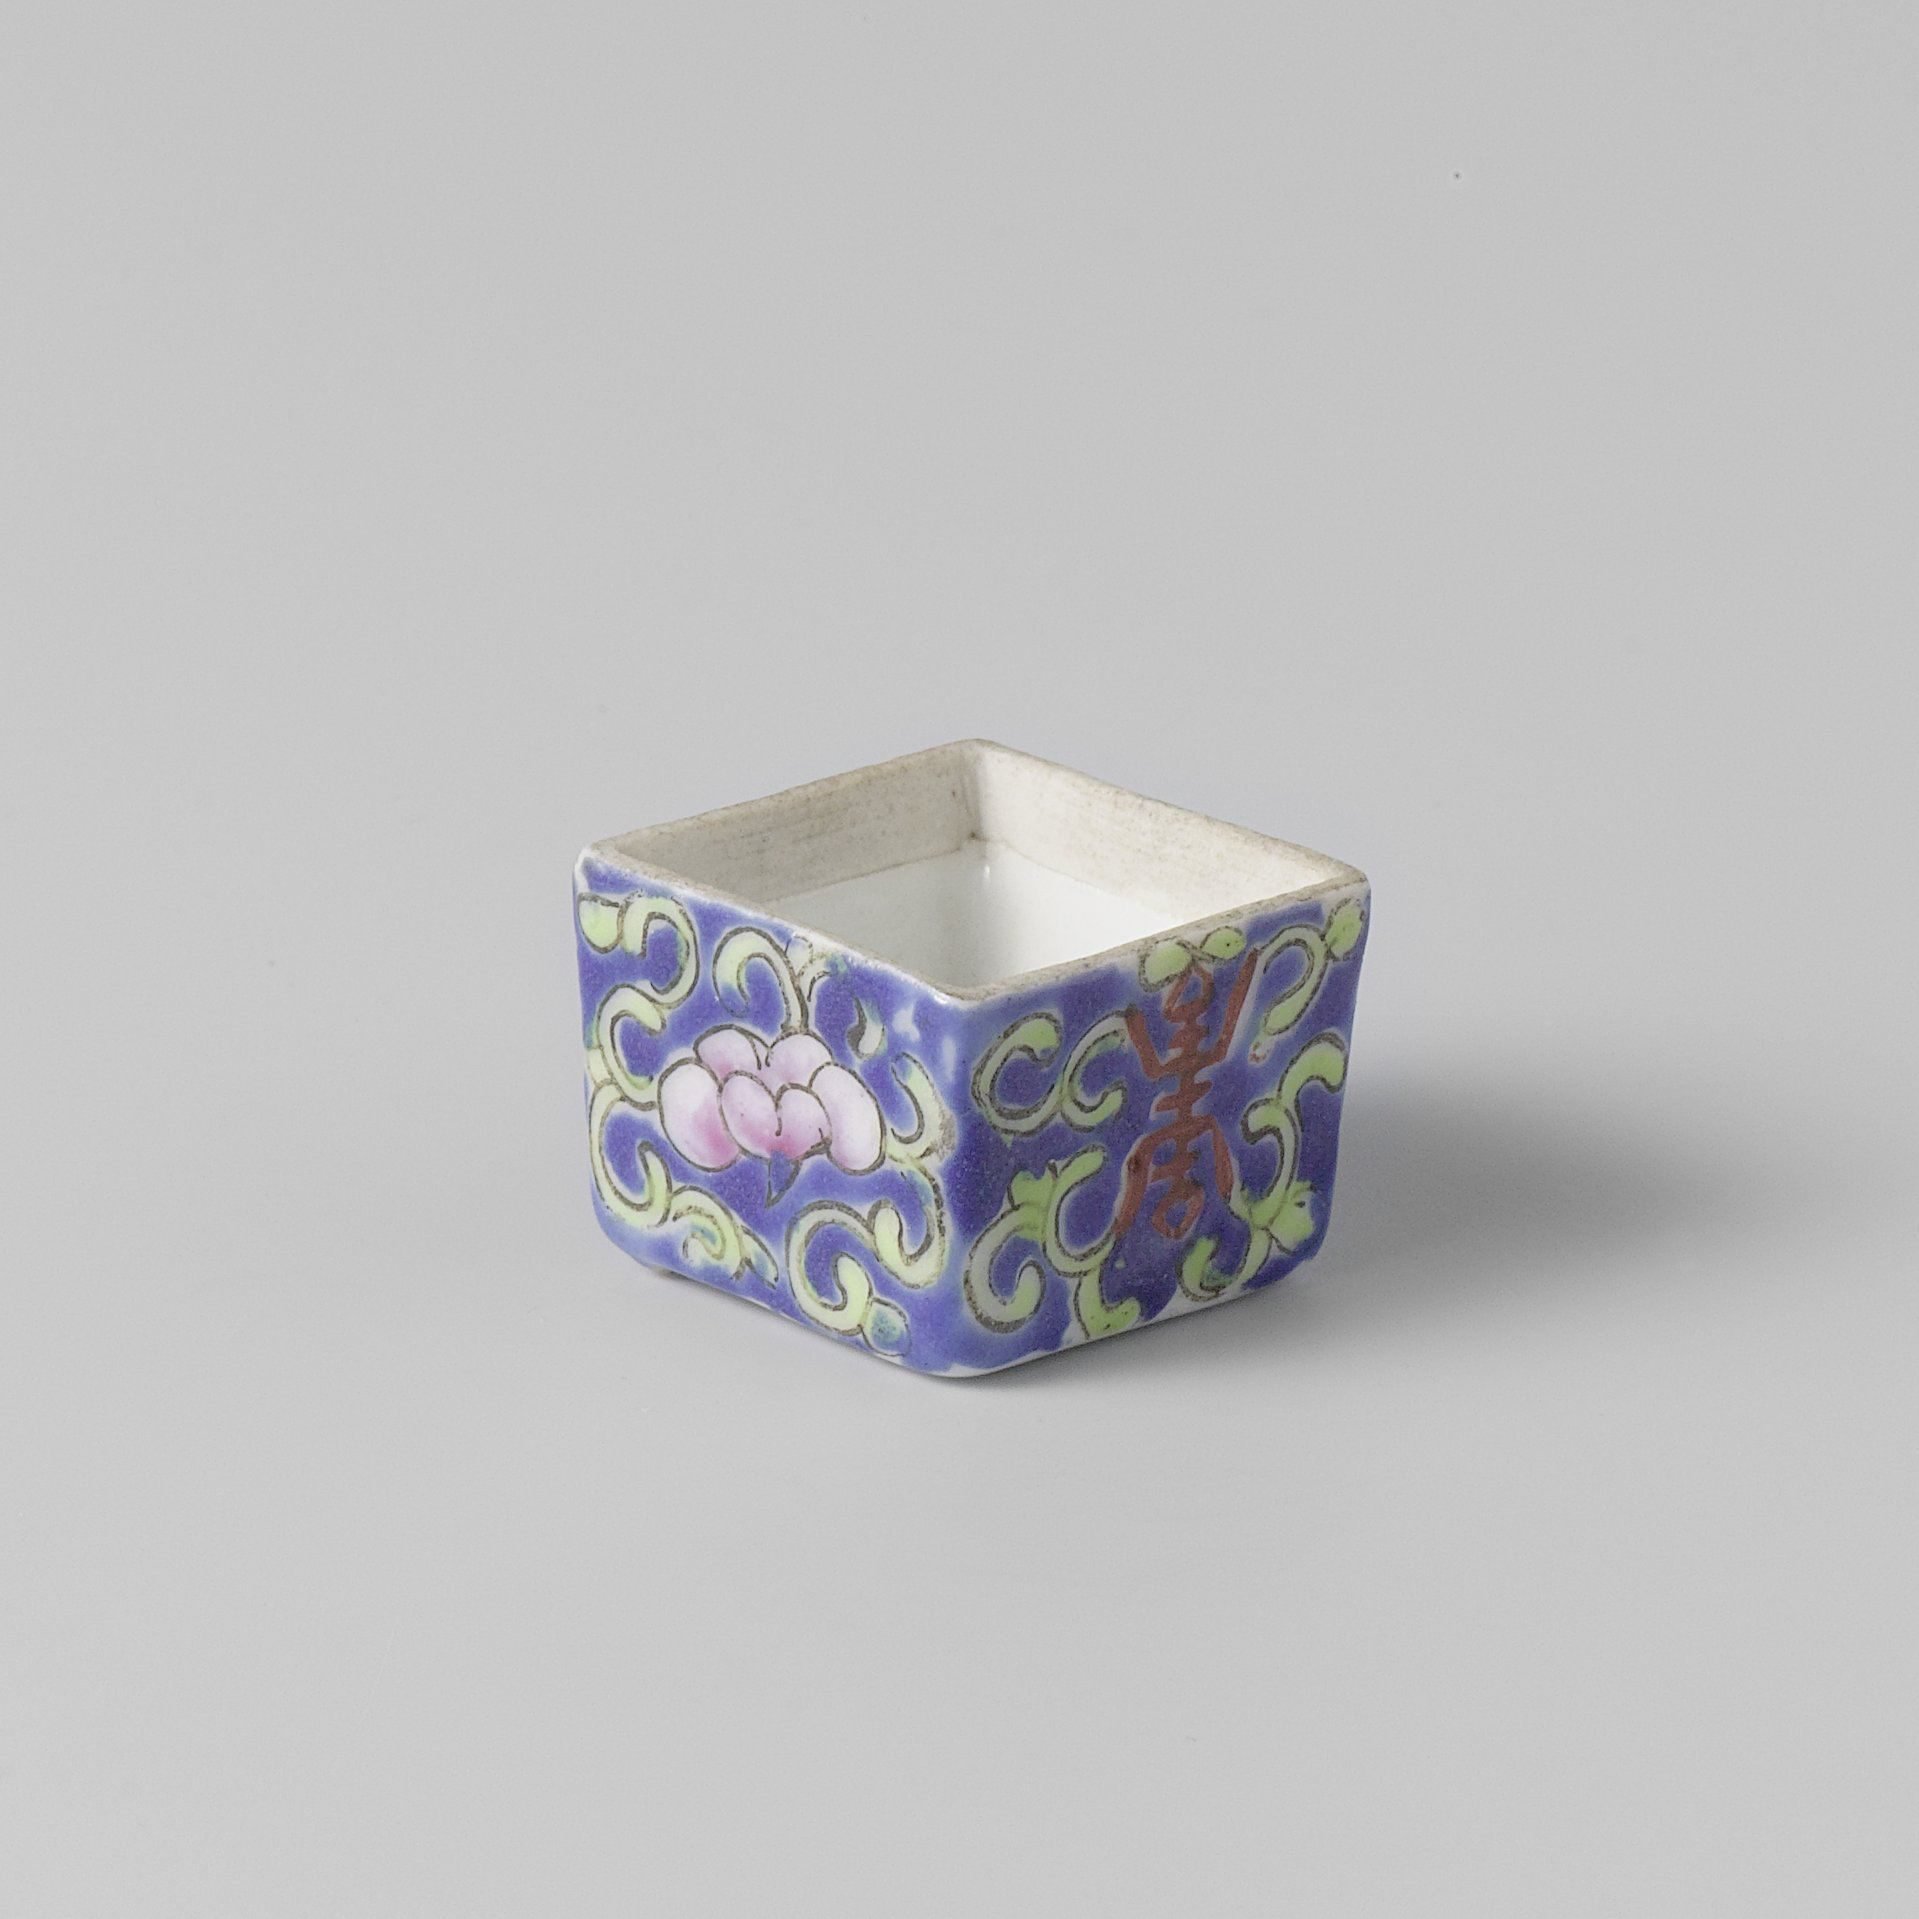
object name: container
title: Square bowl with floral scrolls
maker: Anonymous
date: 1796-1820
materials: glaze, paint, porcelain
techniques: firing, forming, vitrification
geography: china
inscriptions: mark: ‘嘉 慶 年 製 Jiaqing nián zhì’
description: Vierkant bakje van porselein, beschilderd op het glazuur in blauw, rood, roze, groen en zwart. De wanden zijn beschilderd met bloemranken en een karakter tussen ranken. De binnenzijde is deels geglazuurd. Gemerkt op de onderzijde met het vier-karaktermerk van keizer Jiaqing in zegelschrift. Een proen op de onderzijde. Porselein met emailkleuren.